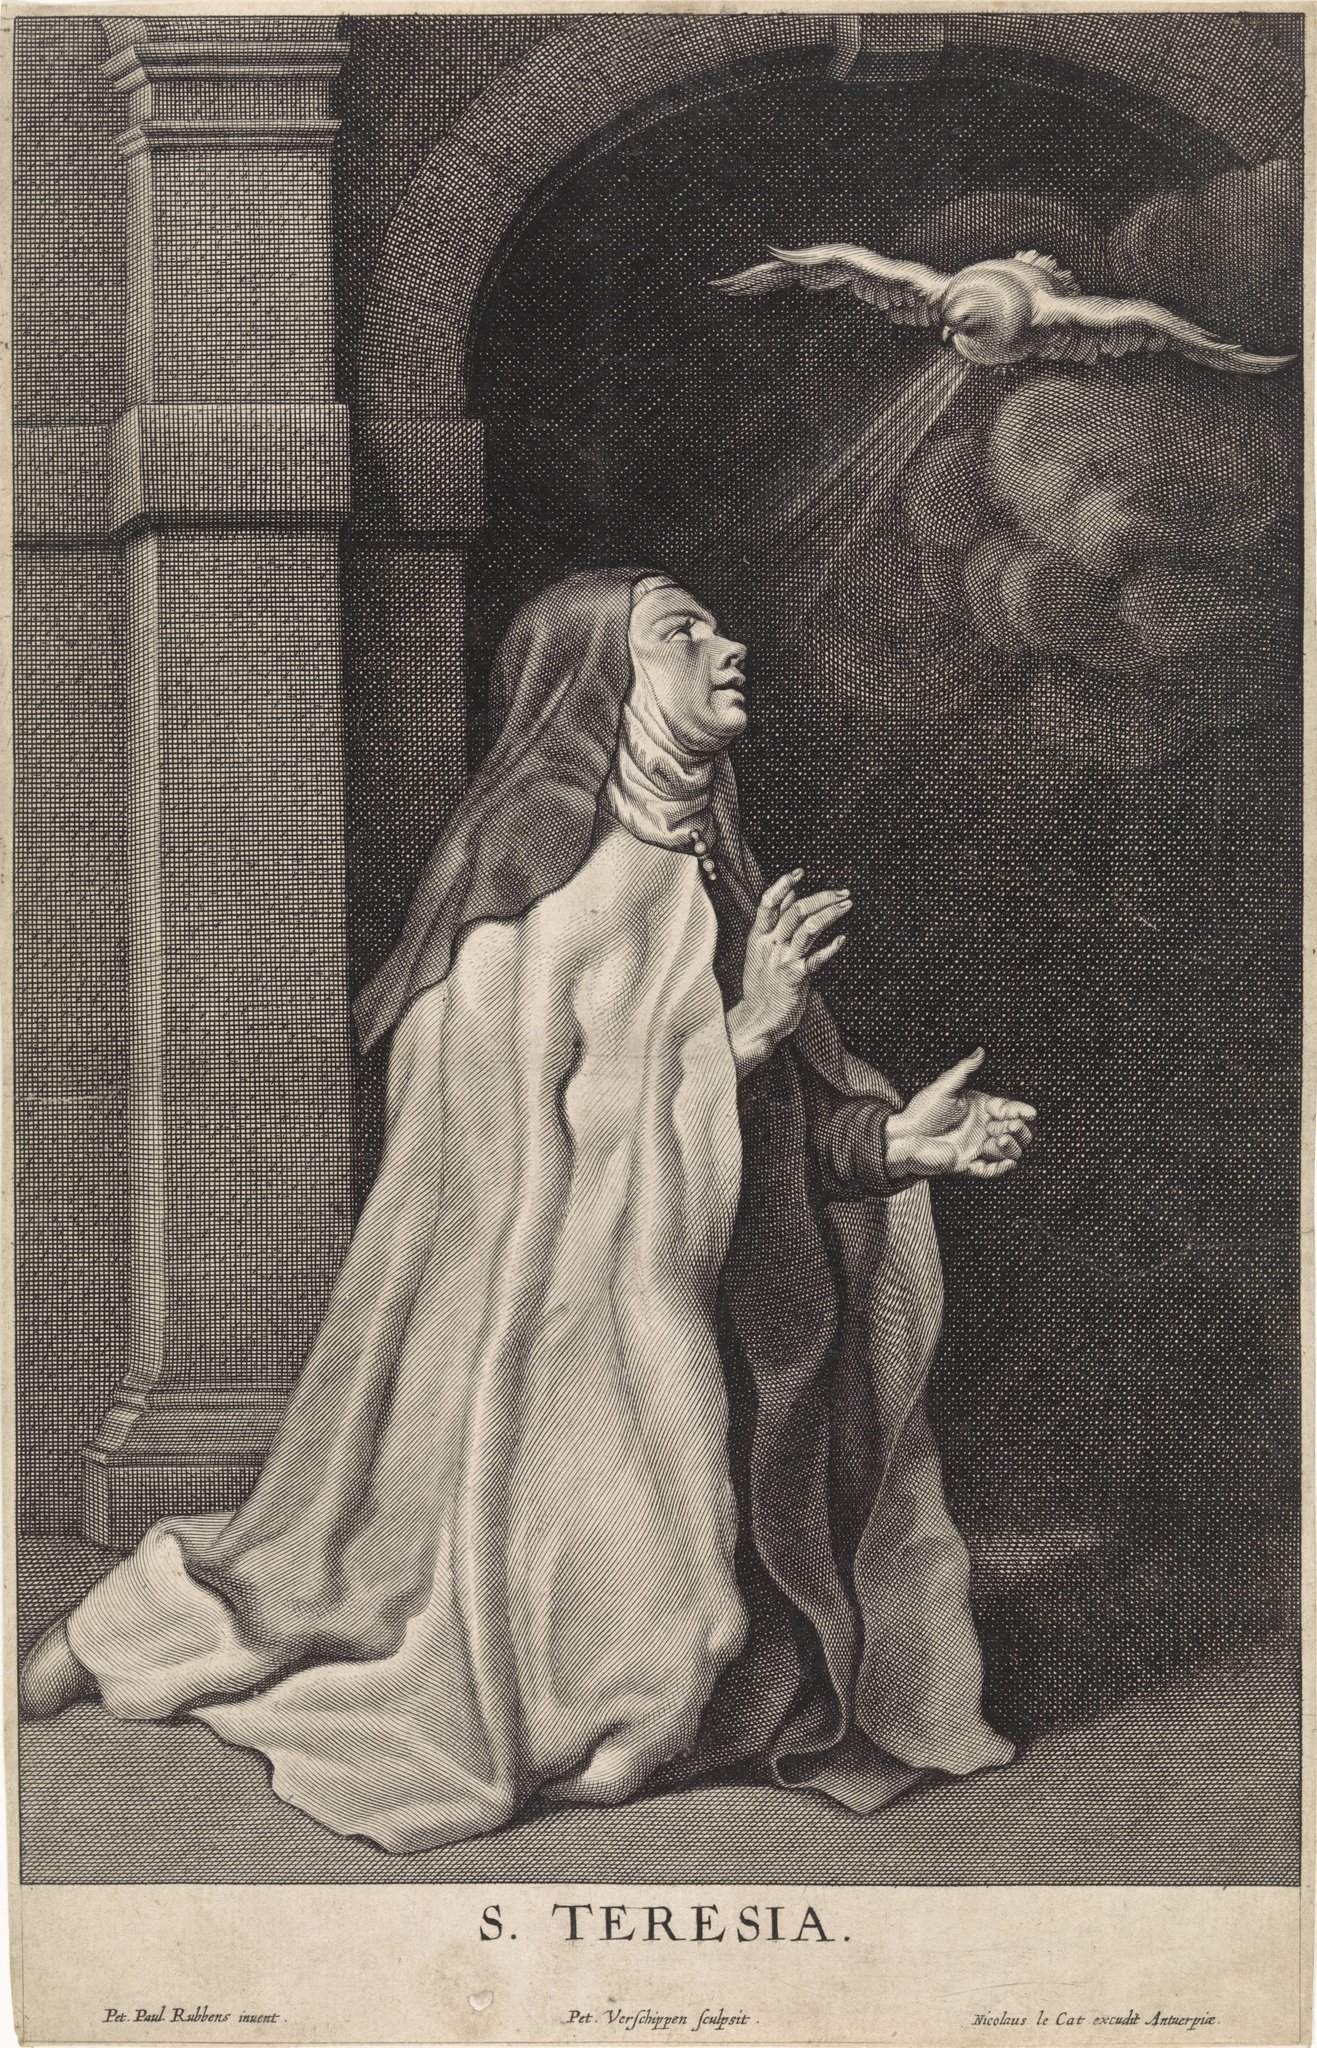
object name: print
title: Het visioen van de H. Teresa van Avilla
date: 1638-1702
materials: paper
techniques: engraving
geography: antwerp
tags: female saints (theresa)(346)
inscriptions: collector's mark: Lugt 240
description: De heilige Teresa zit geknield voor een stenen poort en kijkt op naar een wolk waarin een duif (symbool voor de Heilige Geest) vliegt.